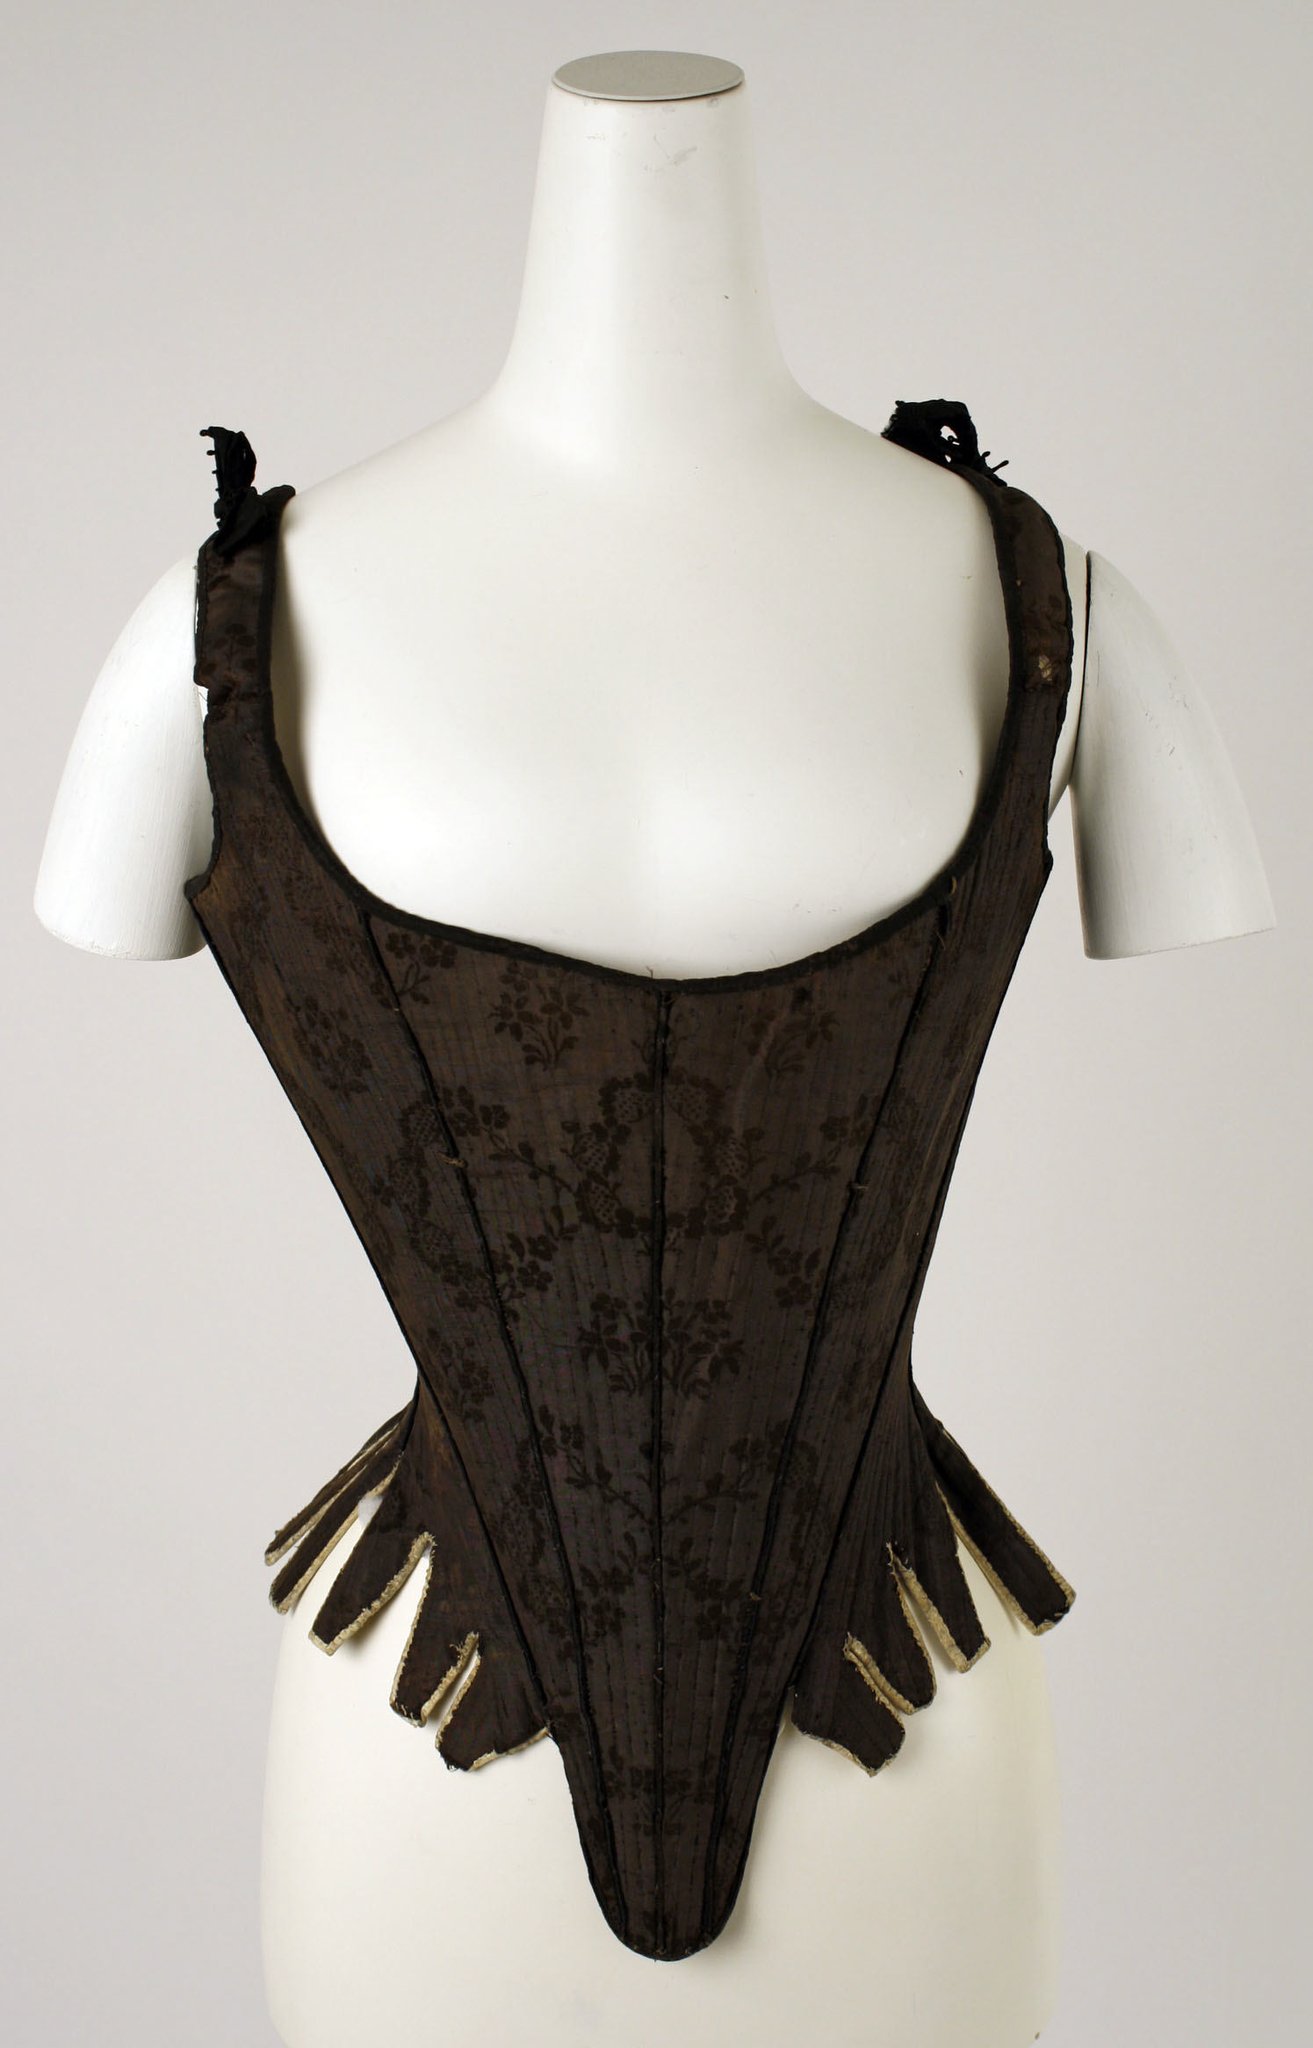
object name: corset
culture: american or european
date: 1701-1800